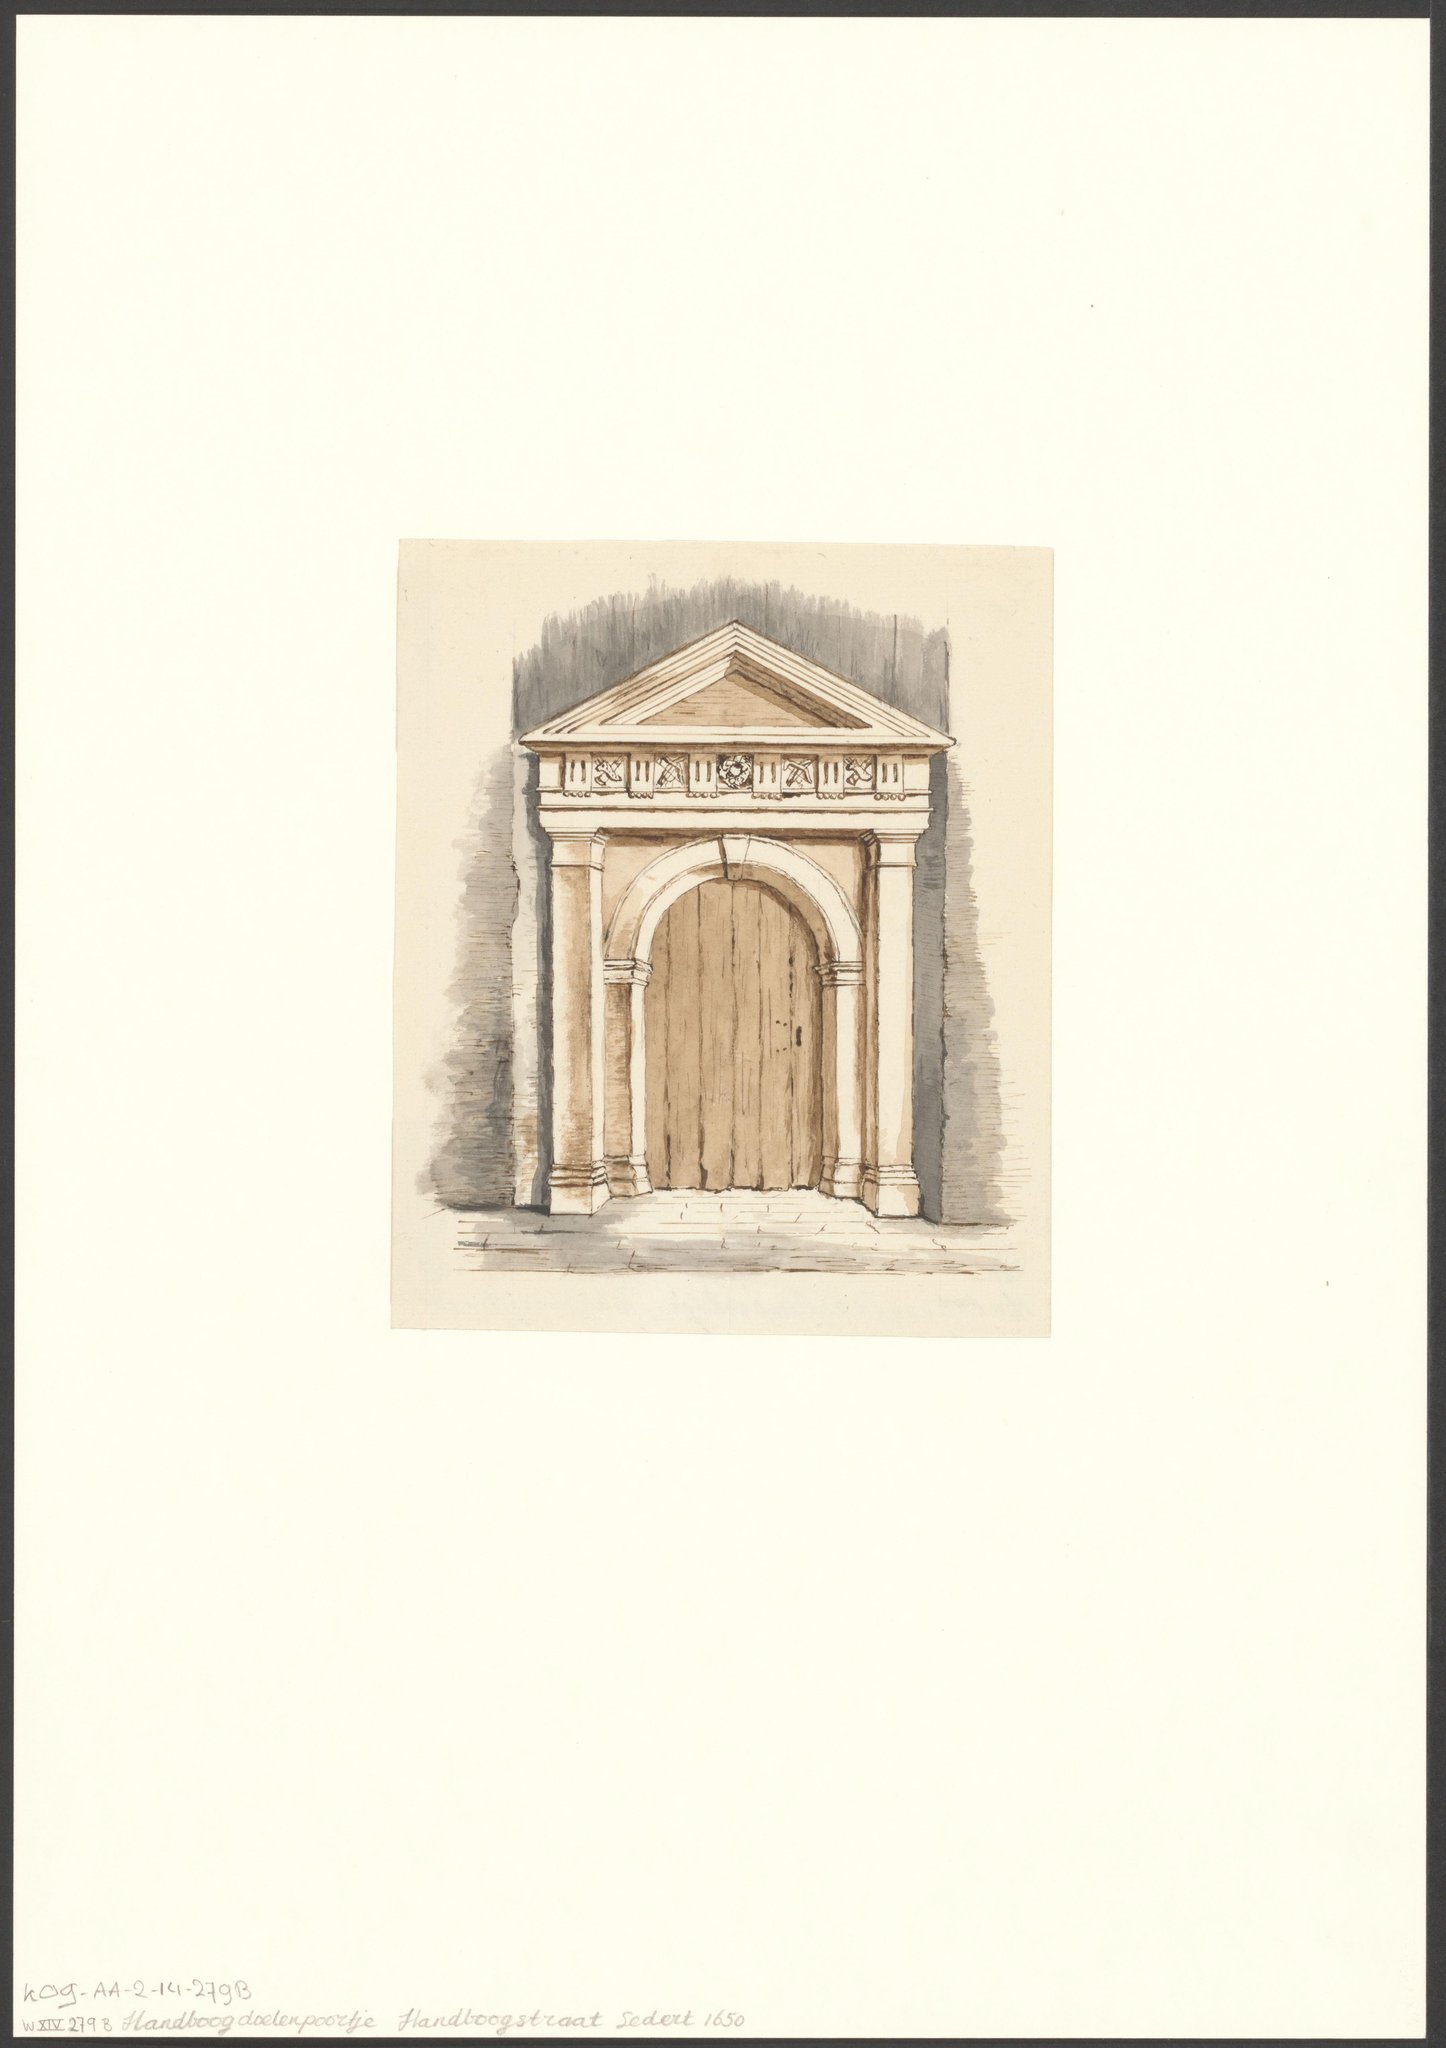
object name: drawing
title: Gezicht op de poort van de Handboogdoelen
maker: Anonymous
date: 1600-1699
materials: ink, paper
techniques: brush, pen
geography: amsterdam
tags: city-view in general; 'veduta', gate, entrance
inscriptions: stamp, inscription: ‘Handboogdoelenpoortje - Handboogstraat’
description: Tekening binnen de Atlas Van Eck ingedeeld op wijknummer 14.